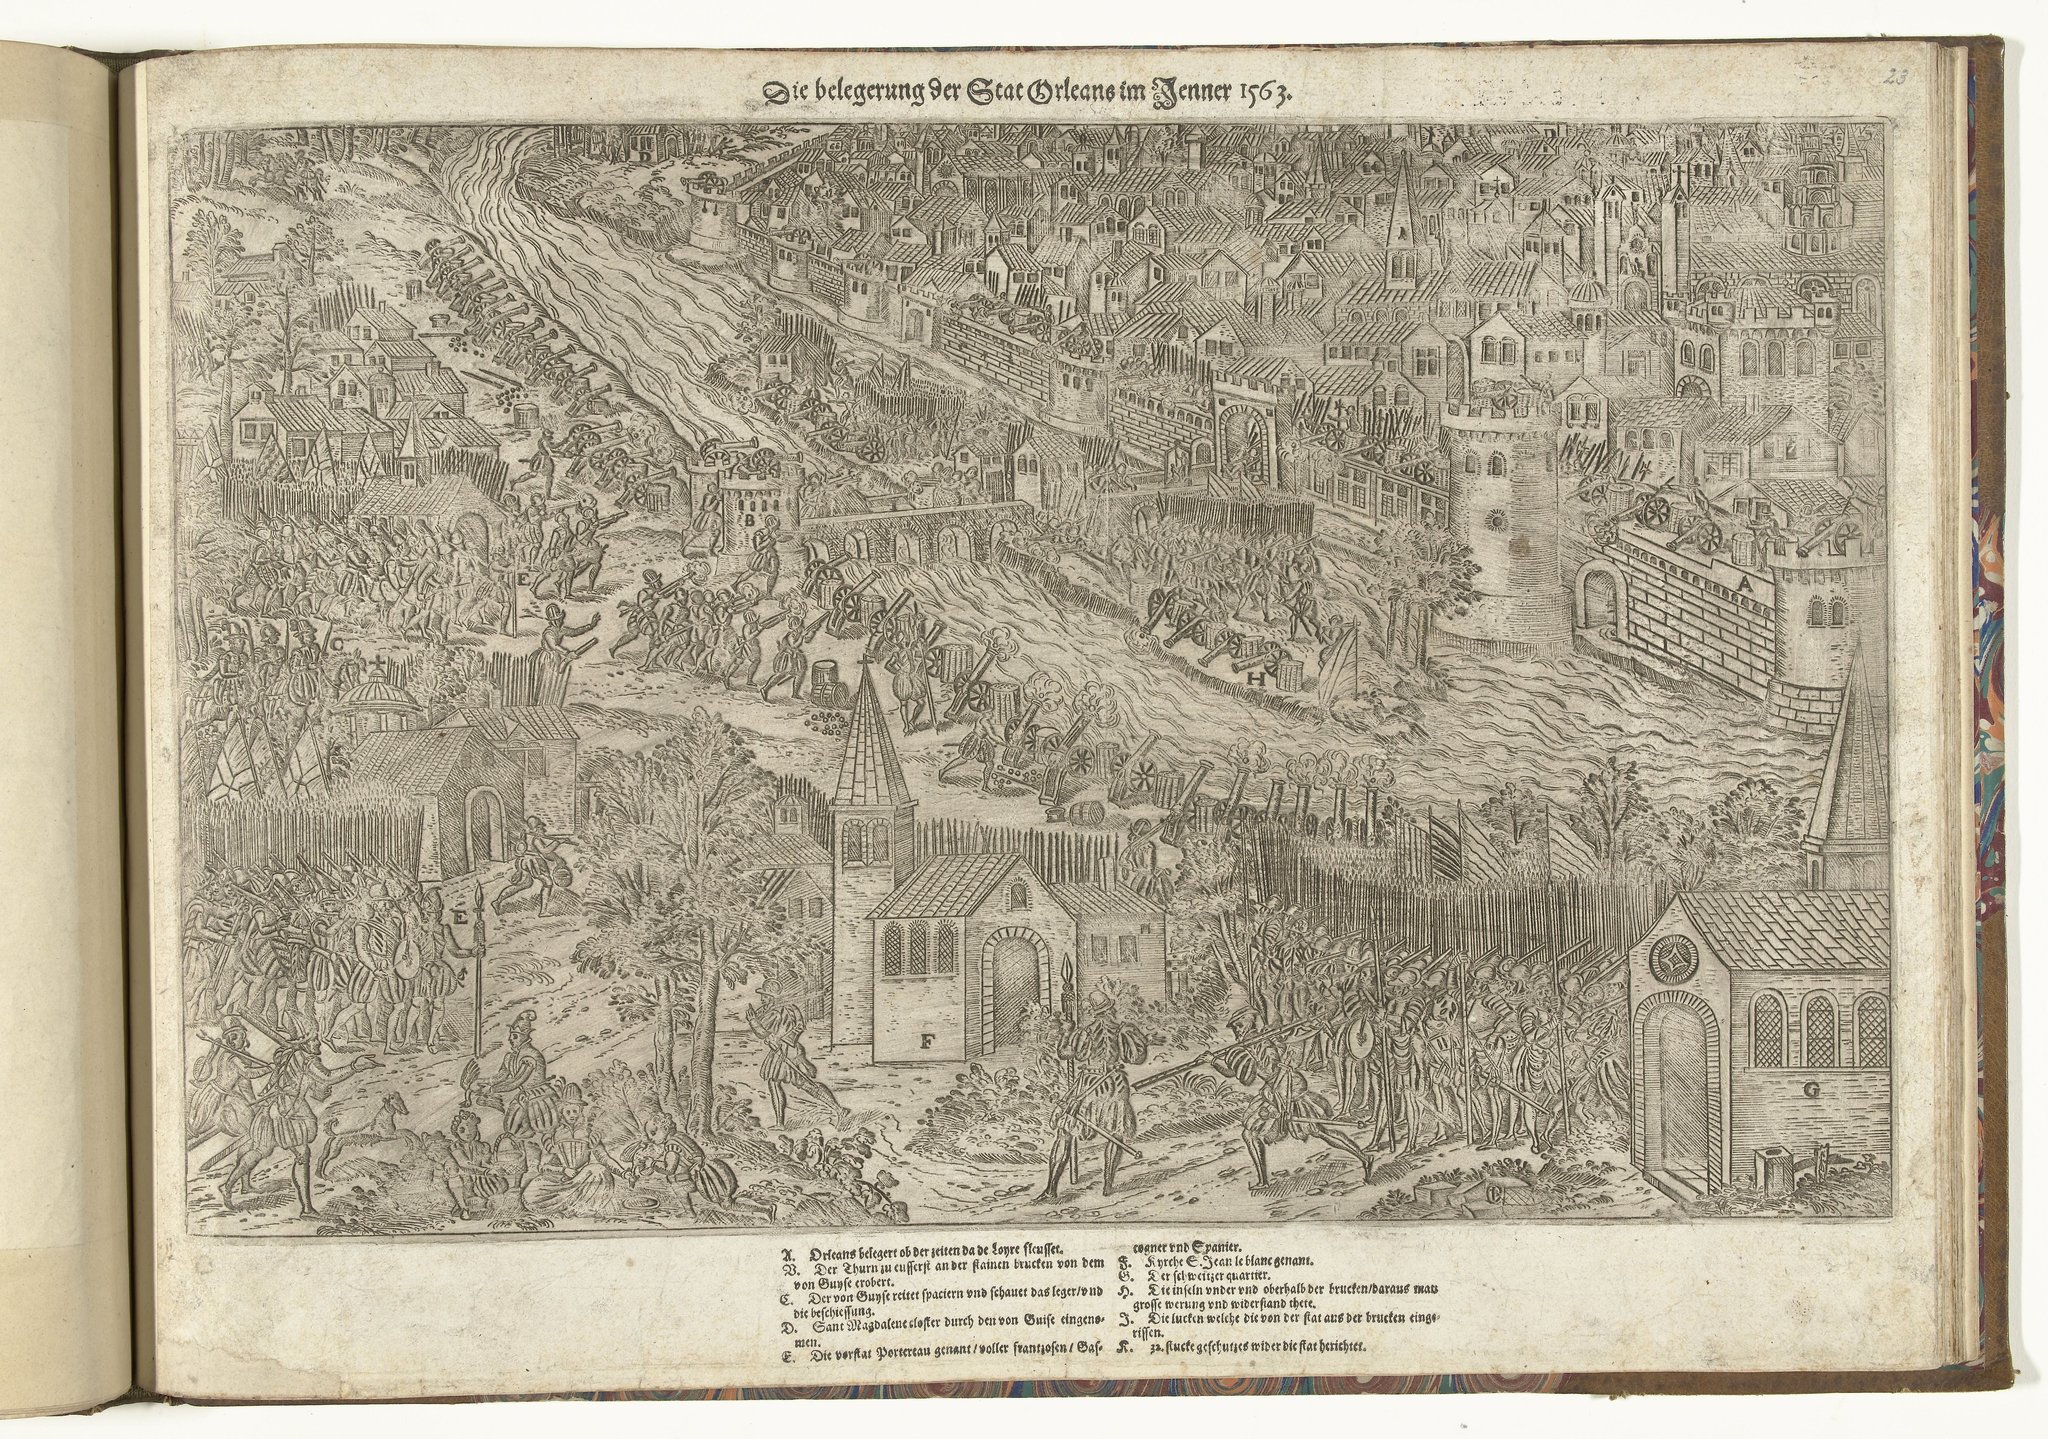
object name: history print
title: Beleg van Orléans, 1563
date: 1570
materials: paper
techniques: etching, letterpress printing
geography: france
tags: siege, position war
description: Beleg van Orléans, januari 1563. Gezicht op de stad vanuit de stellingen van de belegeraars. In het onderschrift de legenda A-K in het Duits. Ongenummerd.